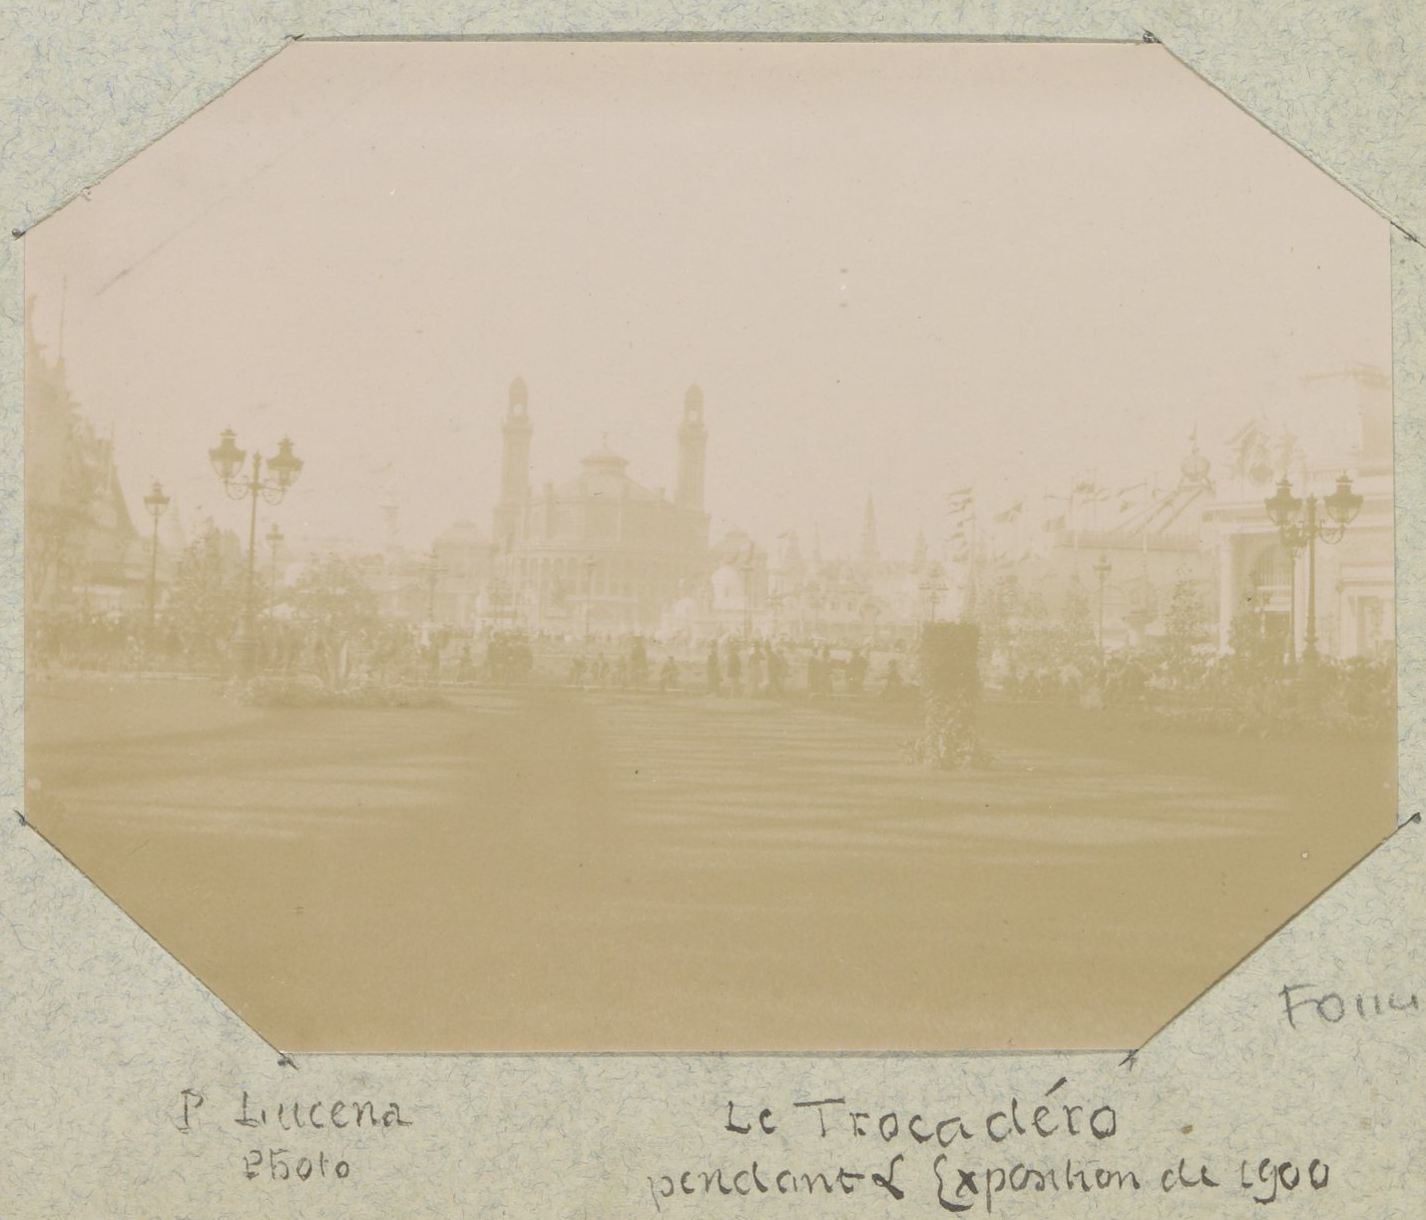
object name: album leaf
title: Gezicht op het Palais du Trocadéro tijdens de Wereldtentoonstelling van 1900 in Parijs, op de voorgrond de schaduw van de Eiffeltoren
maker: paul lucena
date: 1900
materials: paper, photographic support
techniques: albumen print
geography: paris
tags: shadow of an object, palace, paris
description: Onderdeel van Album van een Franse amateur met foto's van Frankrijk, Algerije, Palmyra, de Wereldtentoonstelling van 1900 en van bekende Fransen.